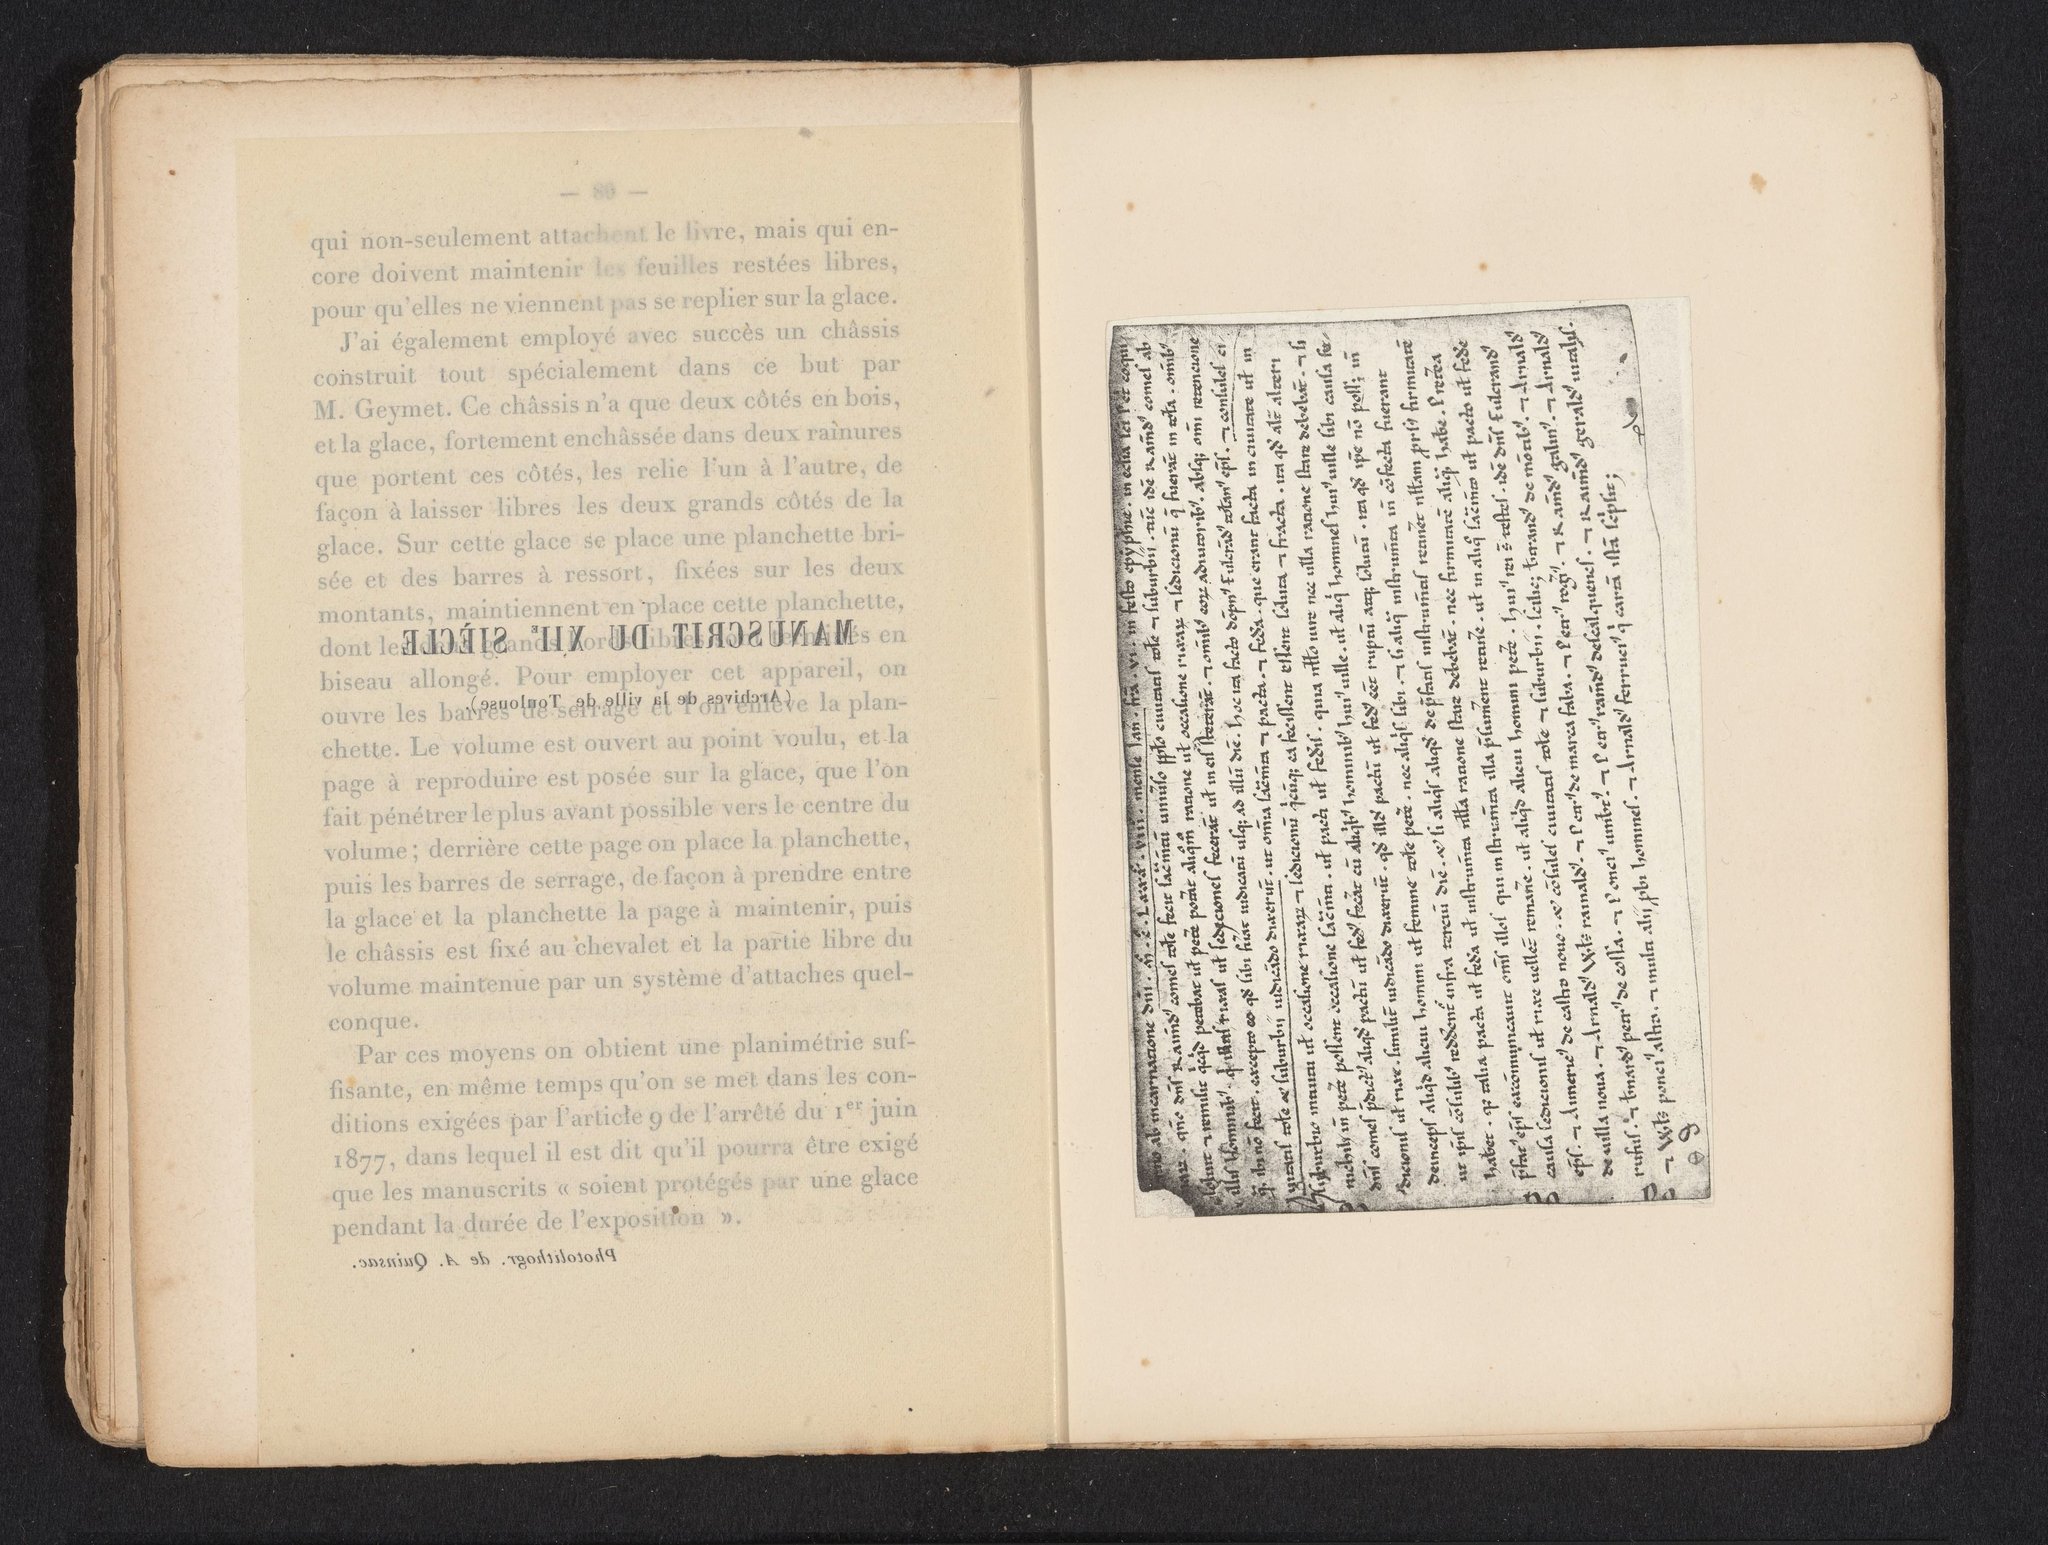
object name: page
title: Manuscript de XIIe Siècle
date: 1869-1879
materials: paper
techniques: photograph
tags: handwriting, written text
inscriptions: inscription: ‘(Archives de la ville de Toulouse).’